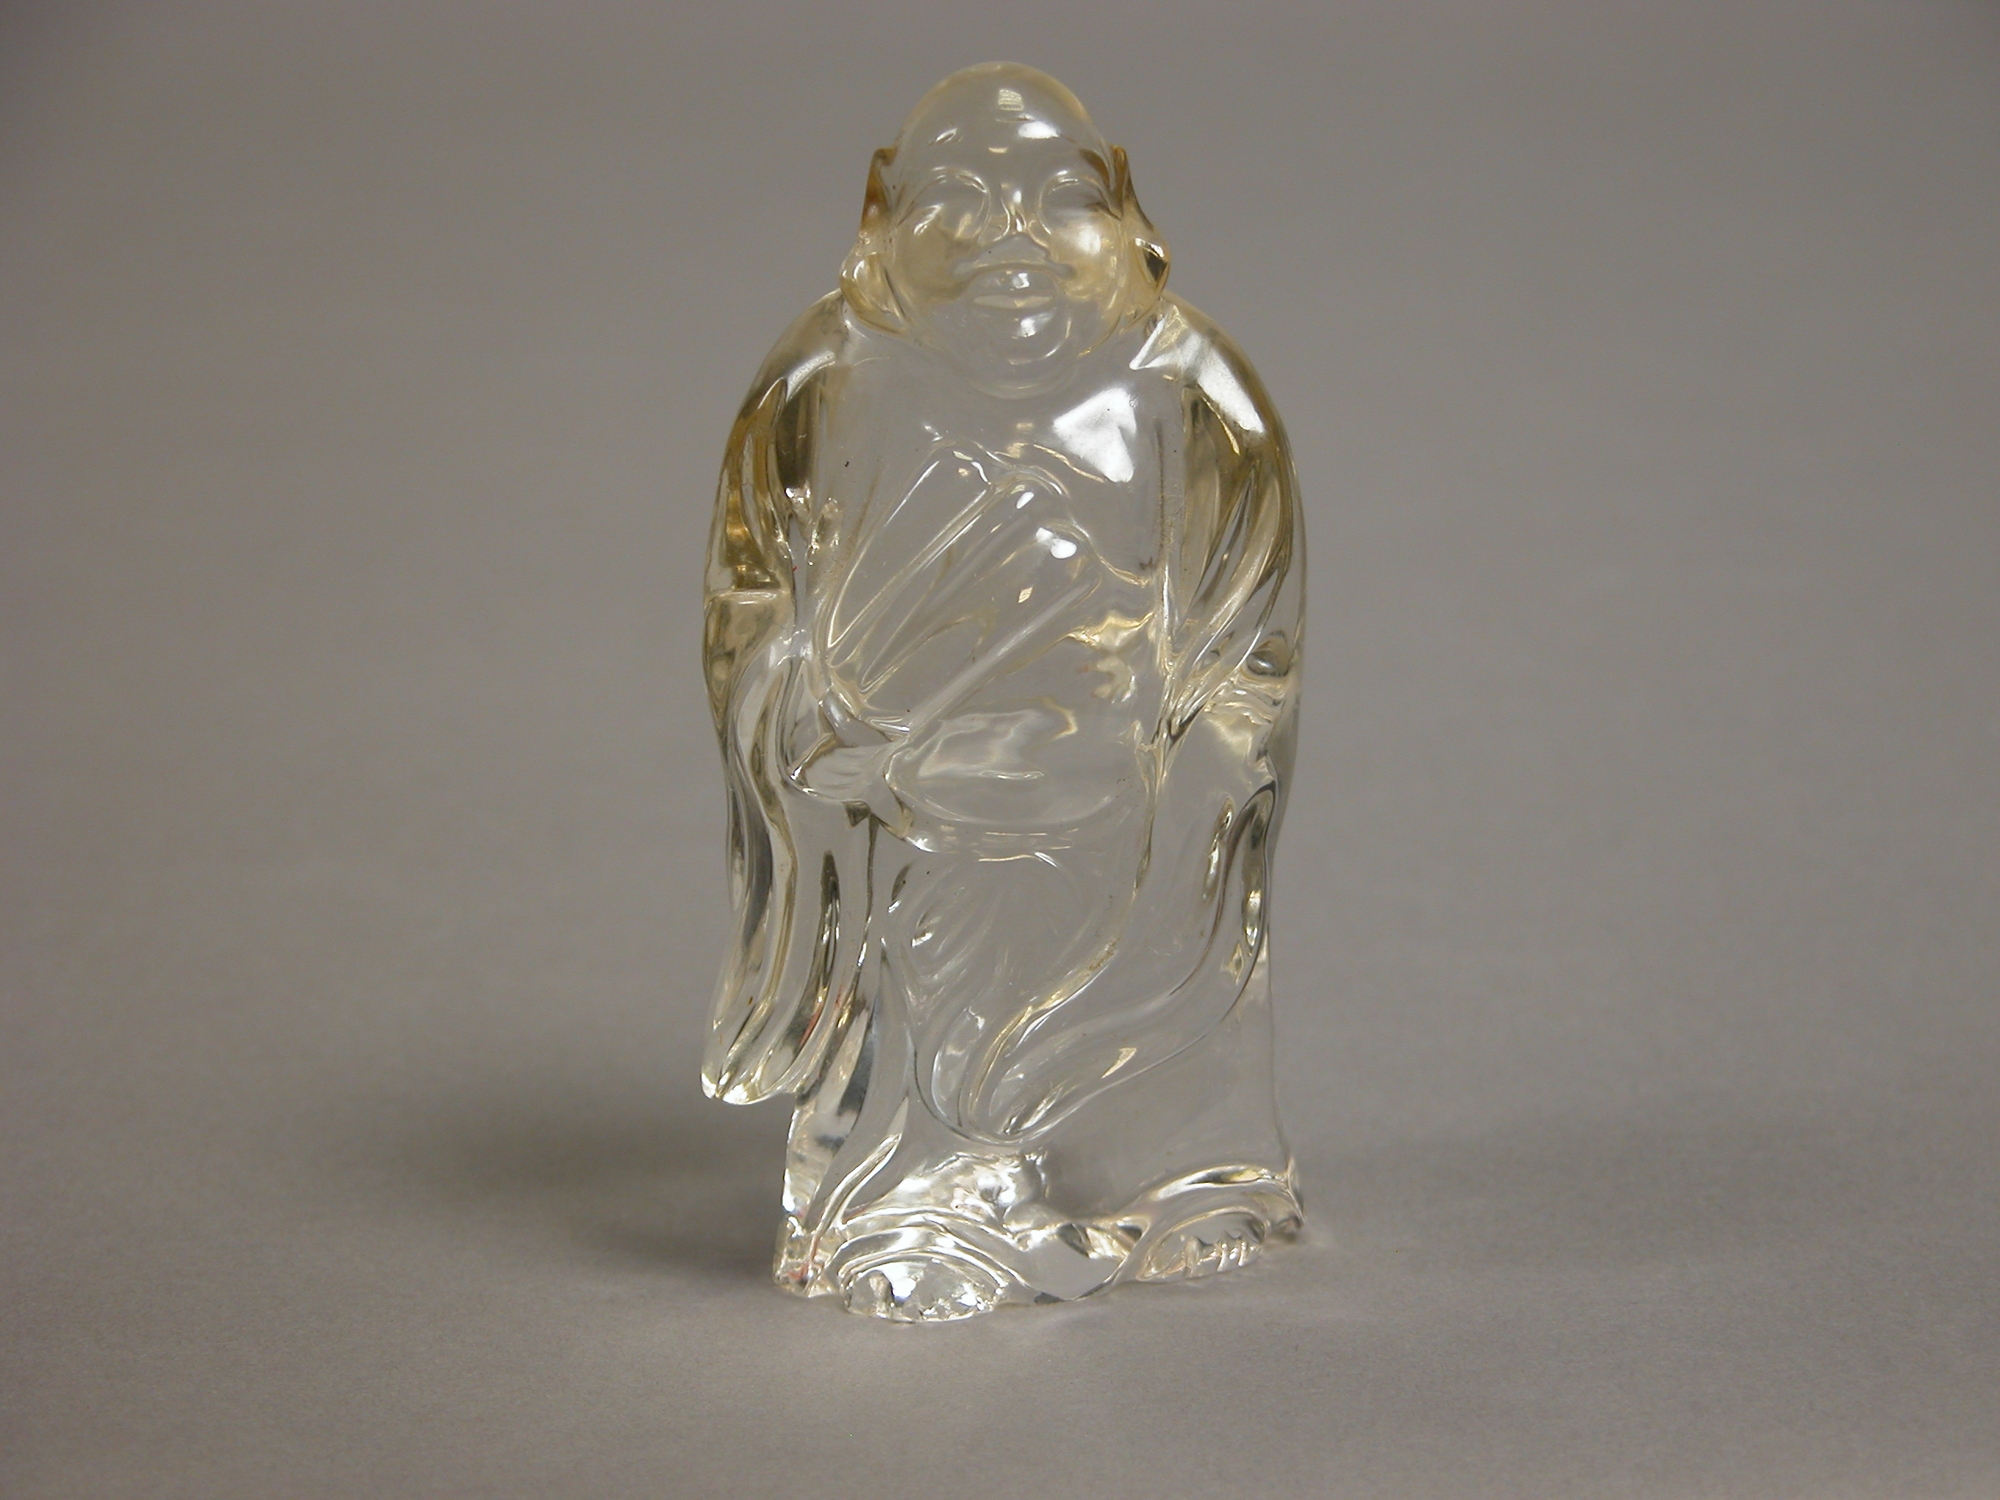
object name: figure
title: Buddha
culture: chinese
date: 1901-2000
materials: quartz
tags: buddhism,buddha